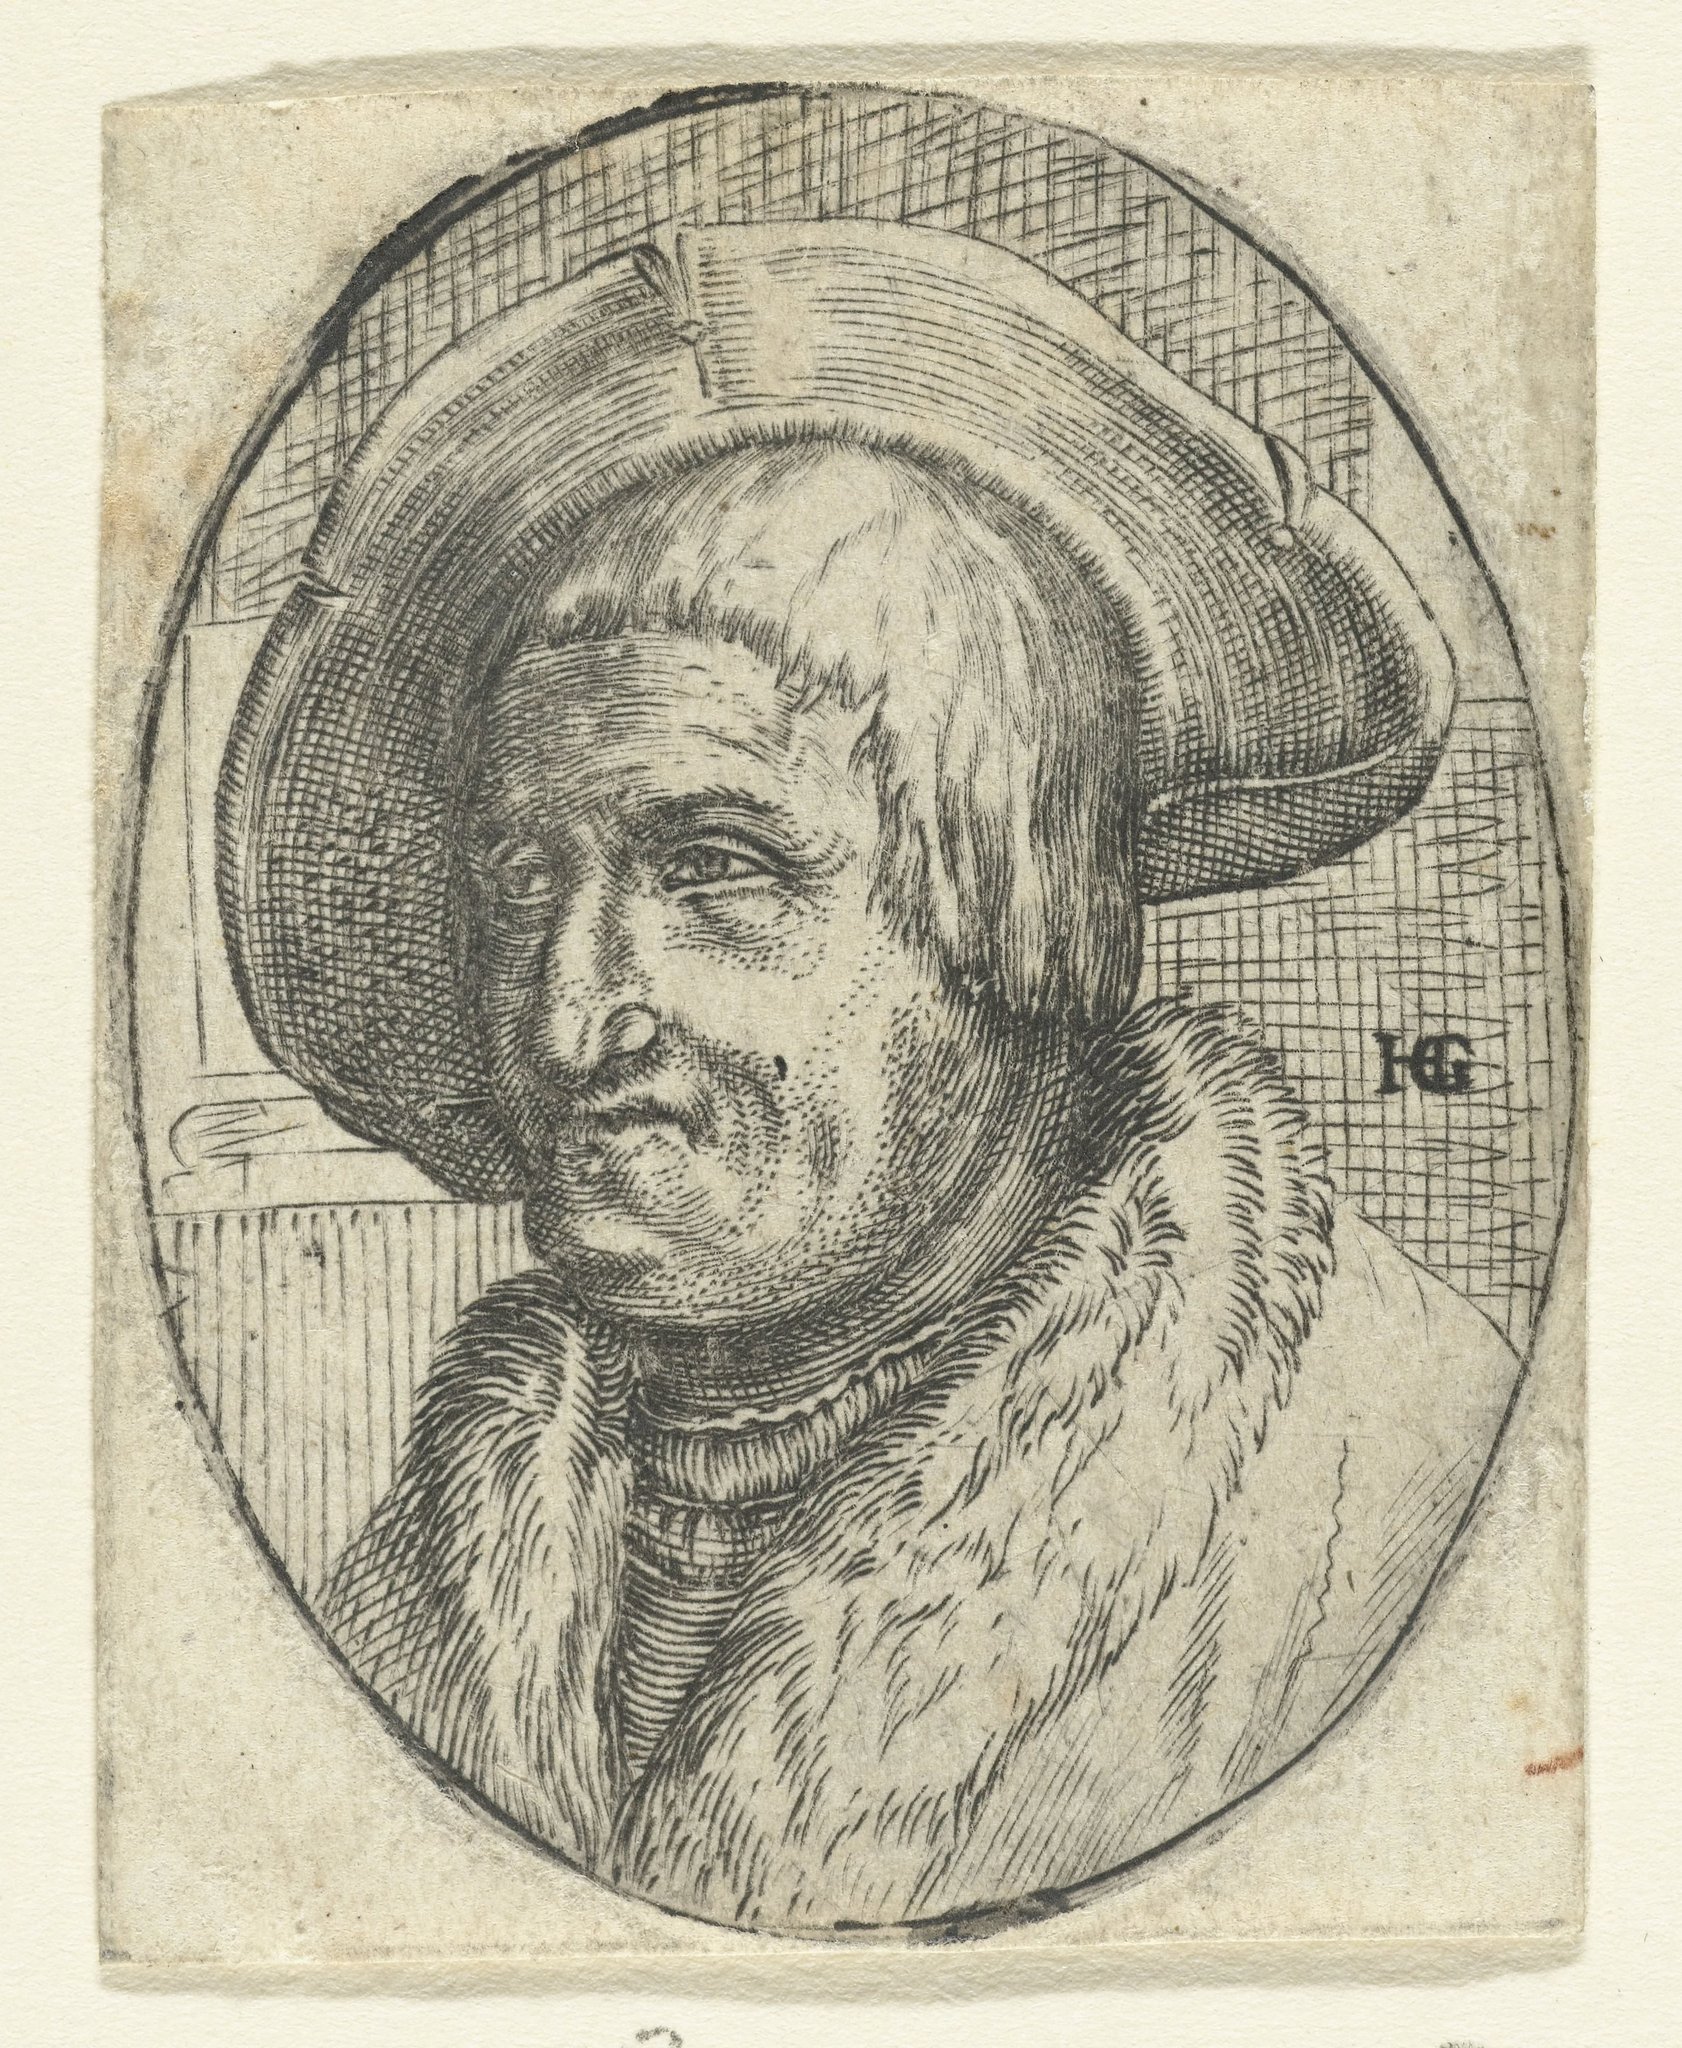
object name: print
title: Portret van een man met een hoed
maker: hendrick goltzius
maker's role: draughtsman, painter, print maker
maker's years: 1558-1617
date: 1597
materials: paper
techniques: engraving, etching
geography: netherlands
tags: anonymous historical person portrayed alone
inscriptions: collector's mark: Lugt 240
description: Ovaal busteportret van een oudere man met een hoed op en een mantel met bontkraag aan, op de linkerzijde gezien.